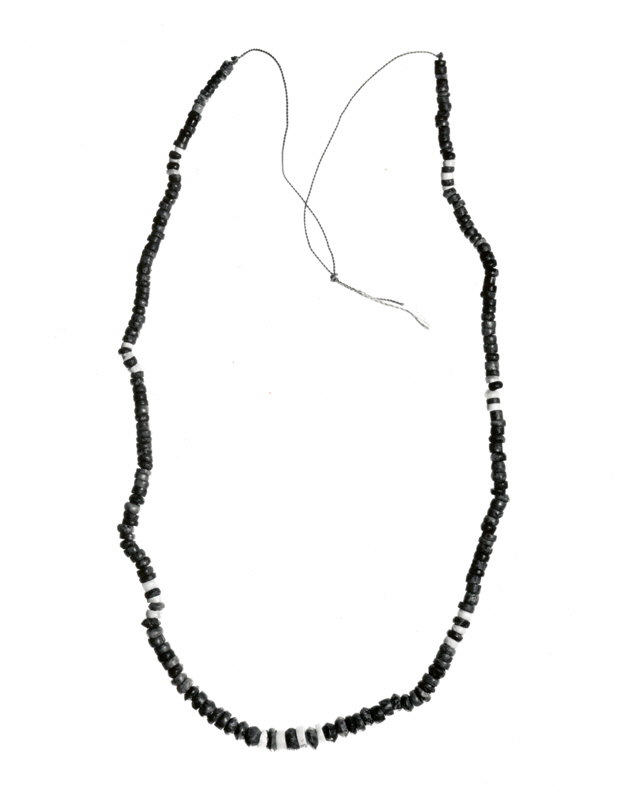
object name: necklace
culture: bactria-margiana archaeological complex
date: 2333-1668 BCE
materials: lapis lazuli, stone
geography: bactria-margiana